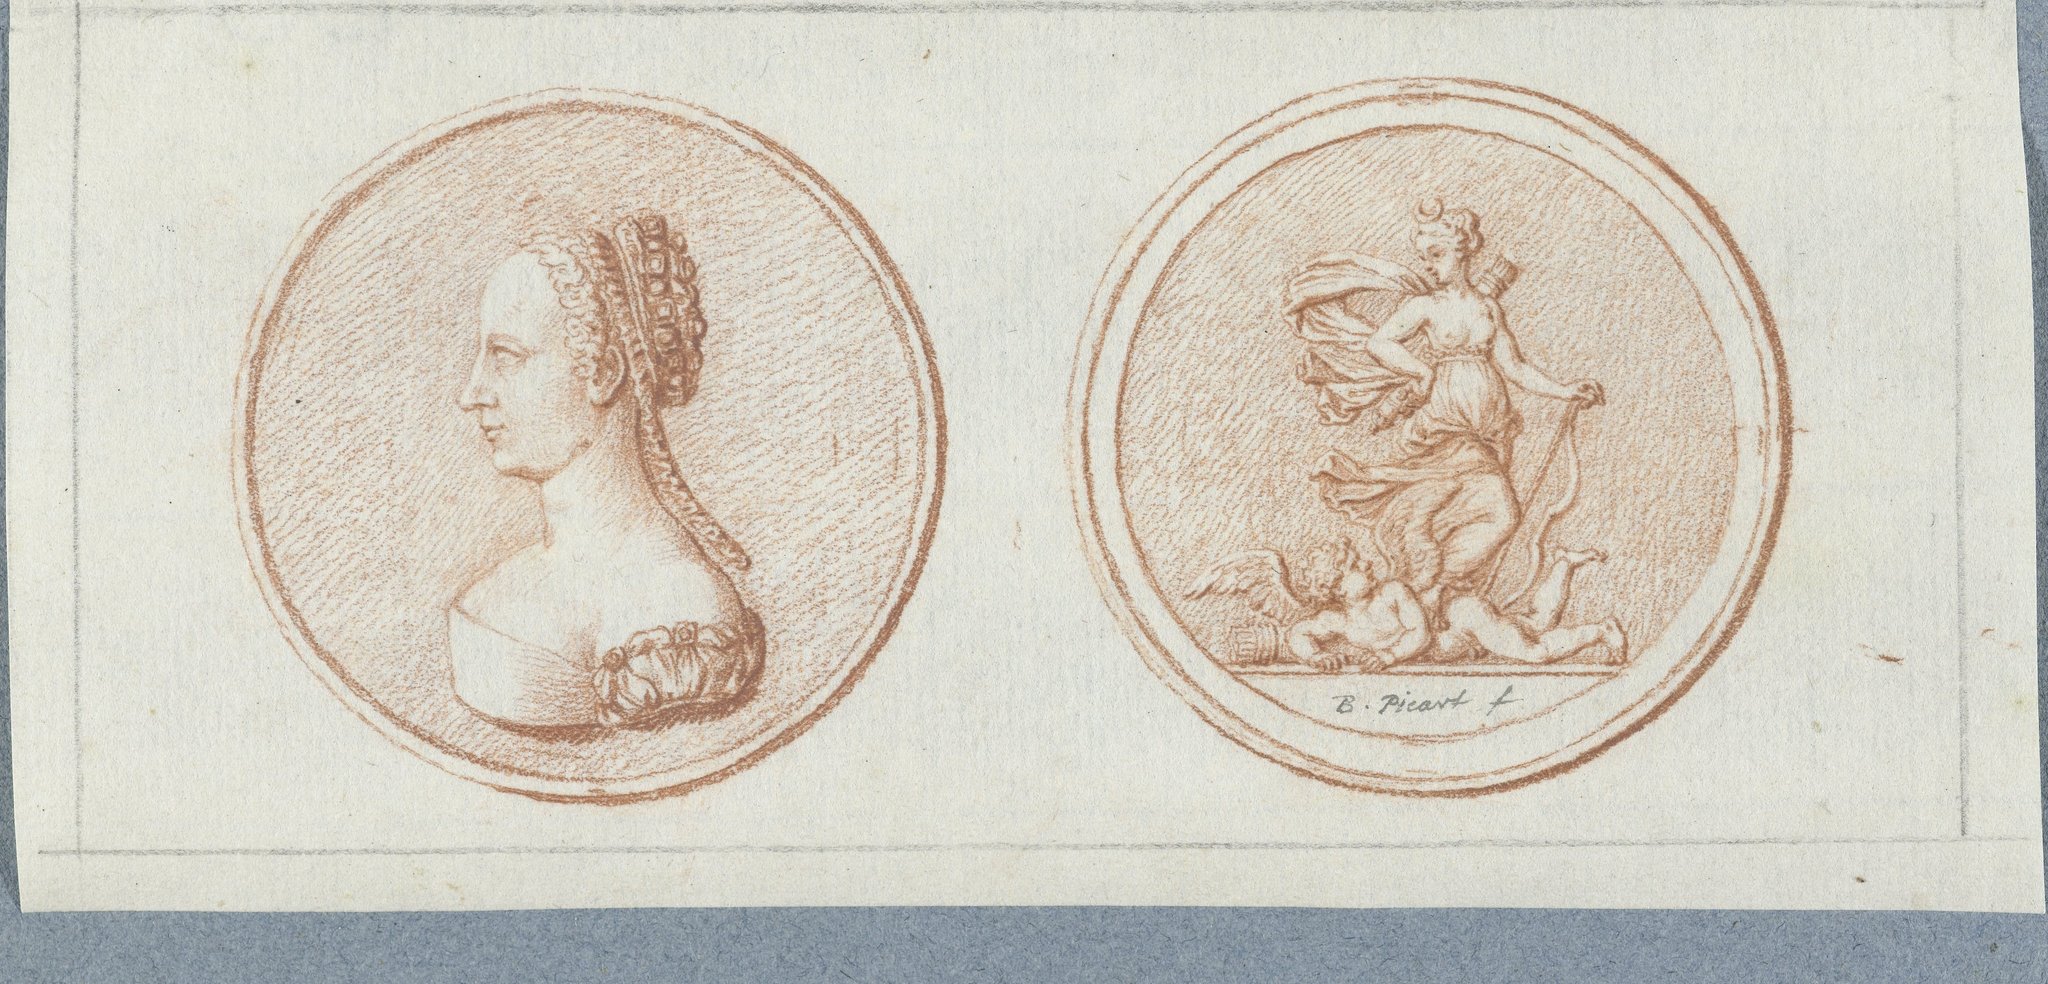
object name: drawing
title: Voor- en achterzijde van een penning met het portret van Diane de Poitiers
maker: bernard picart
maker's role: draughtsman, print maker, publisher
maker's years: 1673-1733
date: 1683-1733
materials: chalk, paper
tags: historical persons, medal (considered as a piece of sculpture, regardless of its specific function)